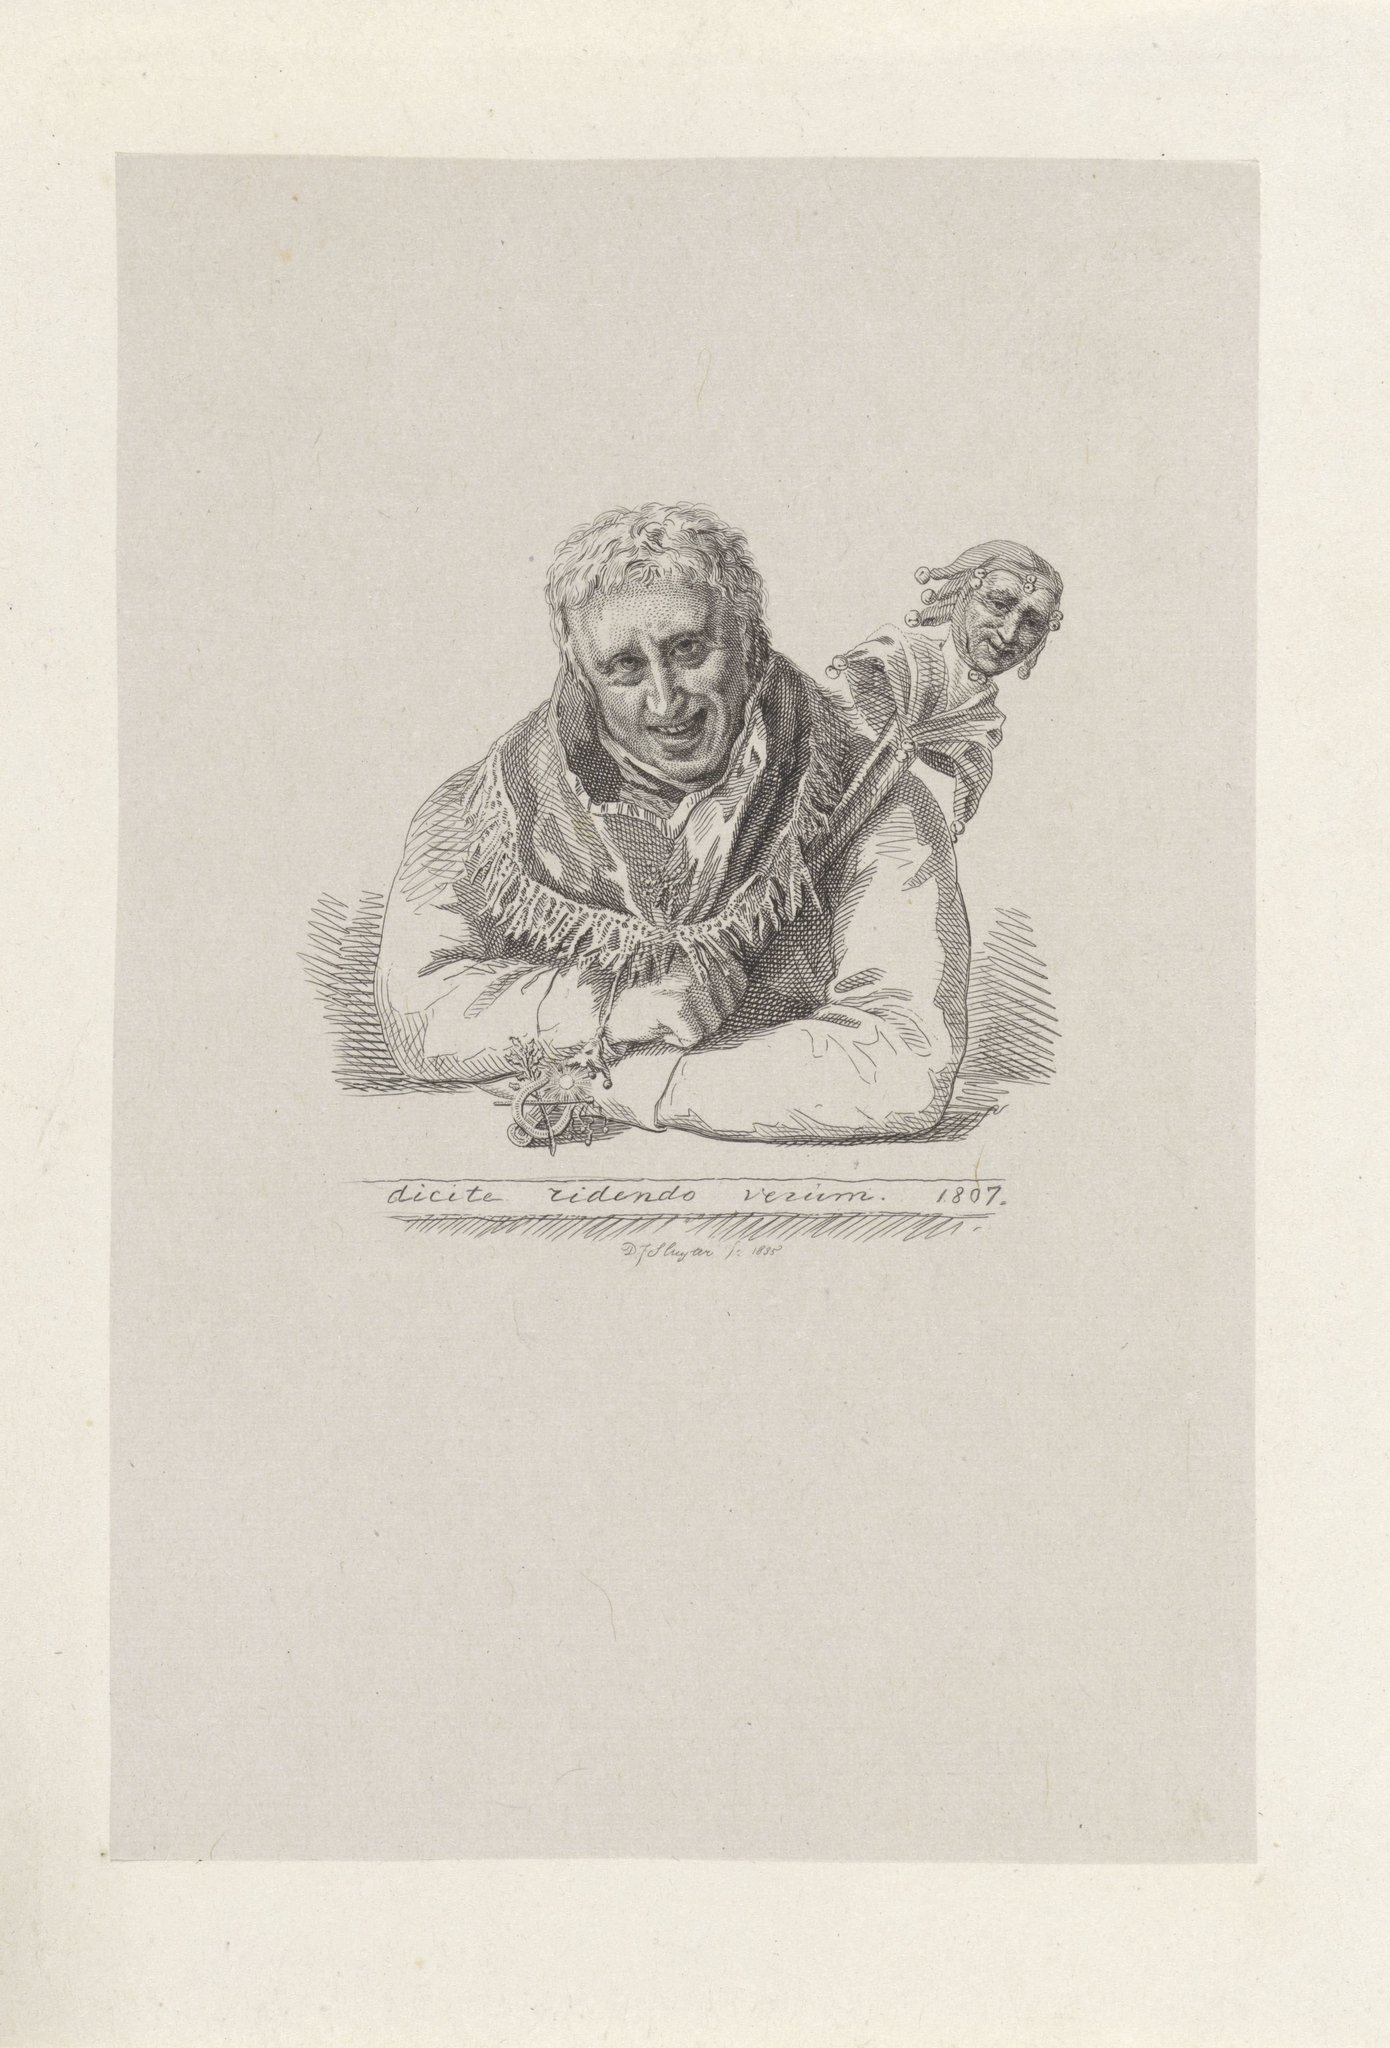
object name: print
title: Portret van Jan van Walré met een narrenstaf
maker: dirk jurriaan sluyter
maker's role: draughtsman, print maker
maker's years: 1811-1886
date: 1835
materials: paper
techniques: engraving, etching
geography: amsterdam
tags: haarlem, publisher, jan van walré, fool's cap, attributes of court jester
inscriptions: collector's mark: Lugt 2228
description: Portret van Jan van Walré met een narrenstaf en een zotskap, gemaakt ter herinnering aan zijn grootmeesterschap van het satyrisch dichtgenootschap Democriet uit Haarlem in 1807. Onder het portet de zinsspreuk 'Dicite ridendo verum'.